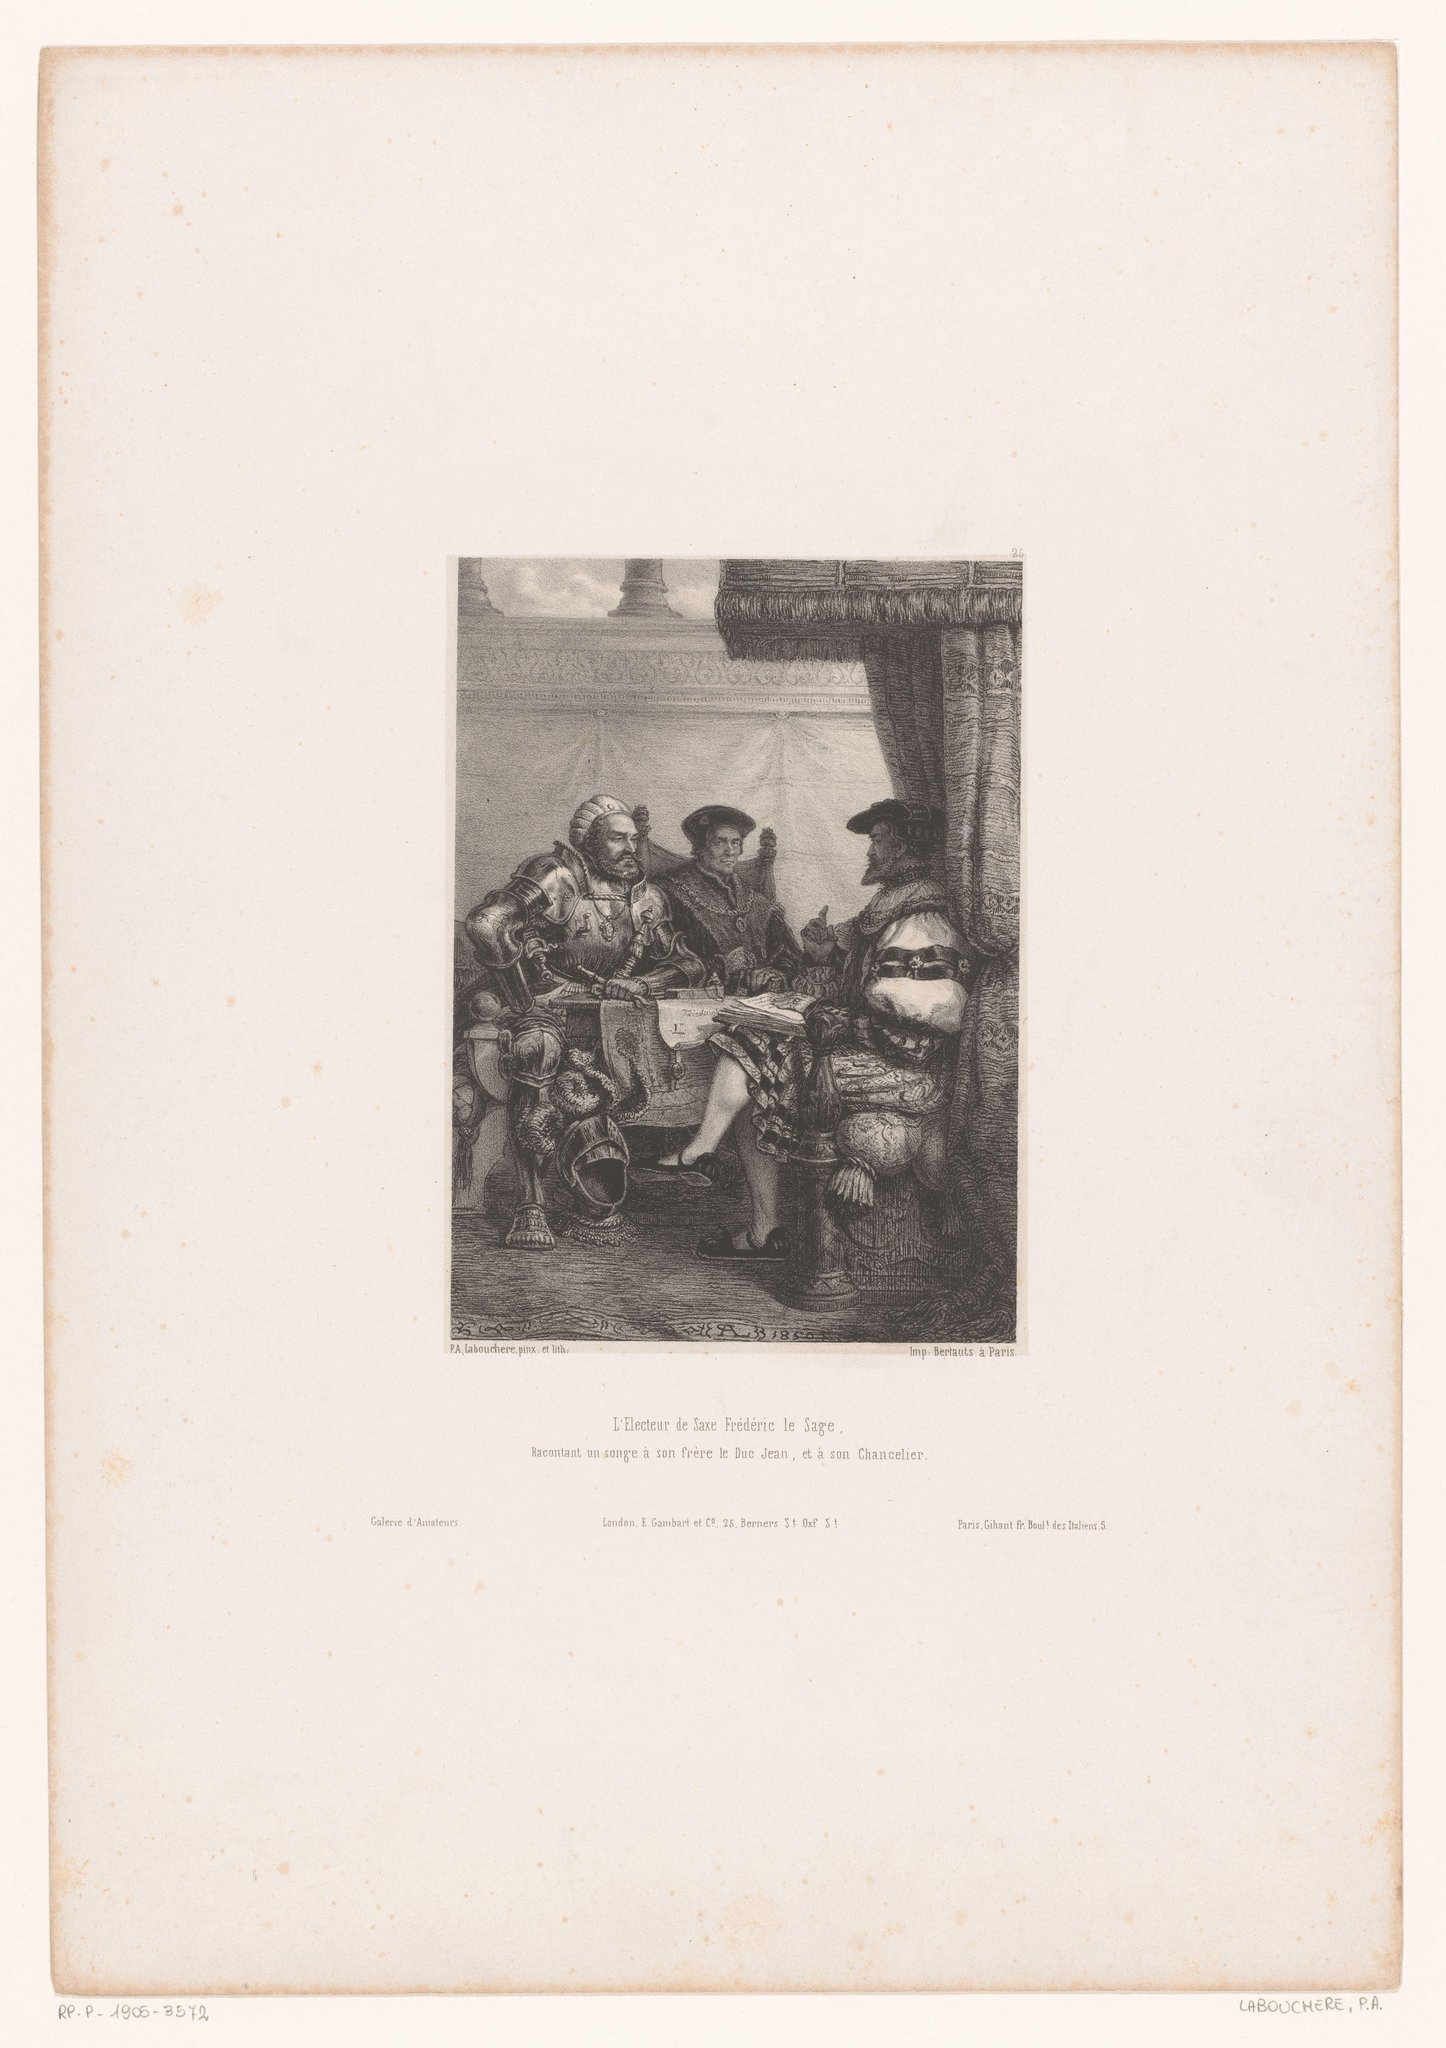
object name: print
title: Galerie d'Amateurs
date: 1850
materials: paper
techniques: lithograph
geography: paris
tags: historical persons, interpreting a dream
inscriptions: collector's mark: Lugt 2228a